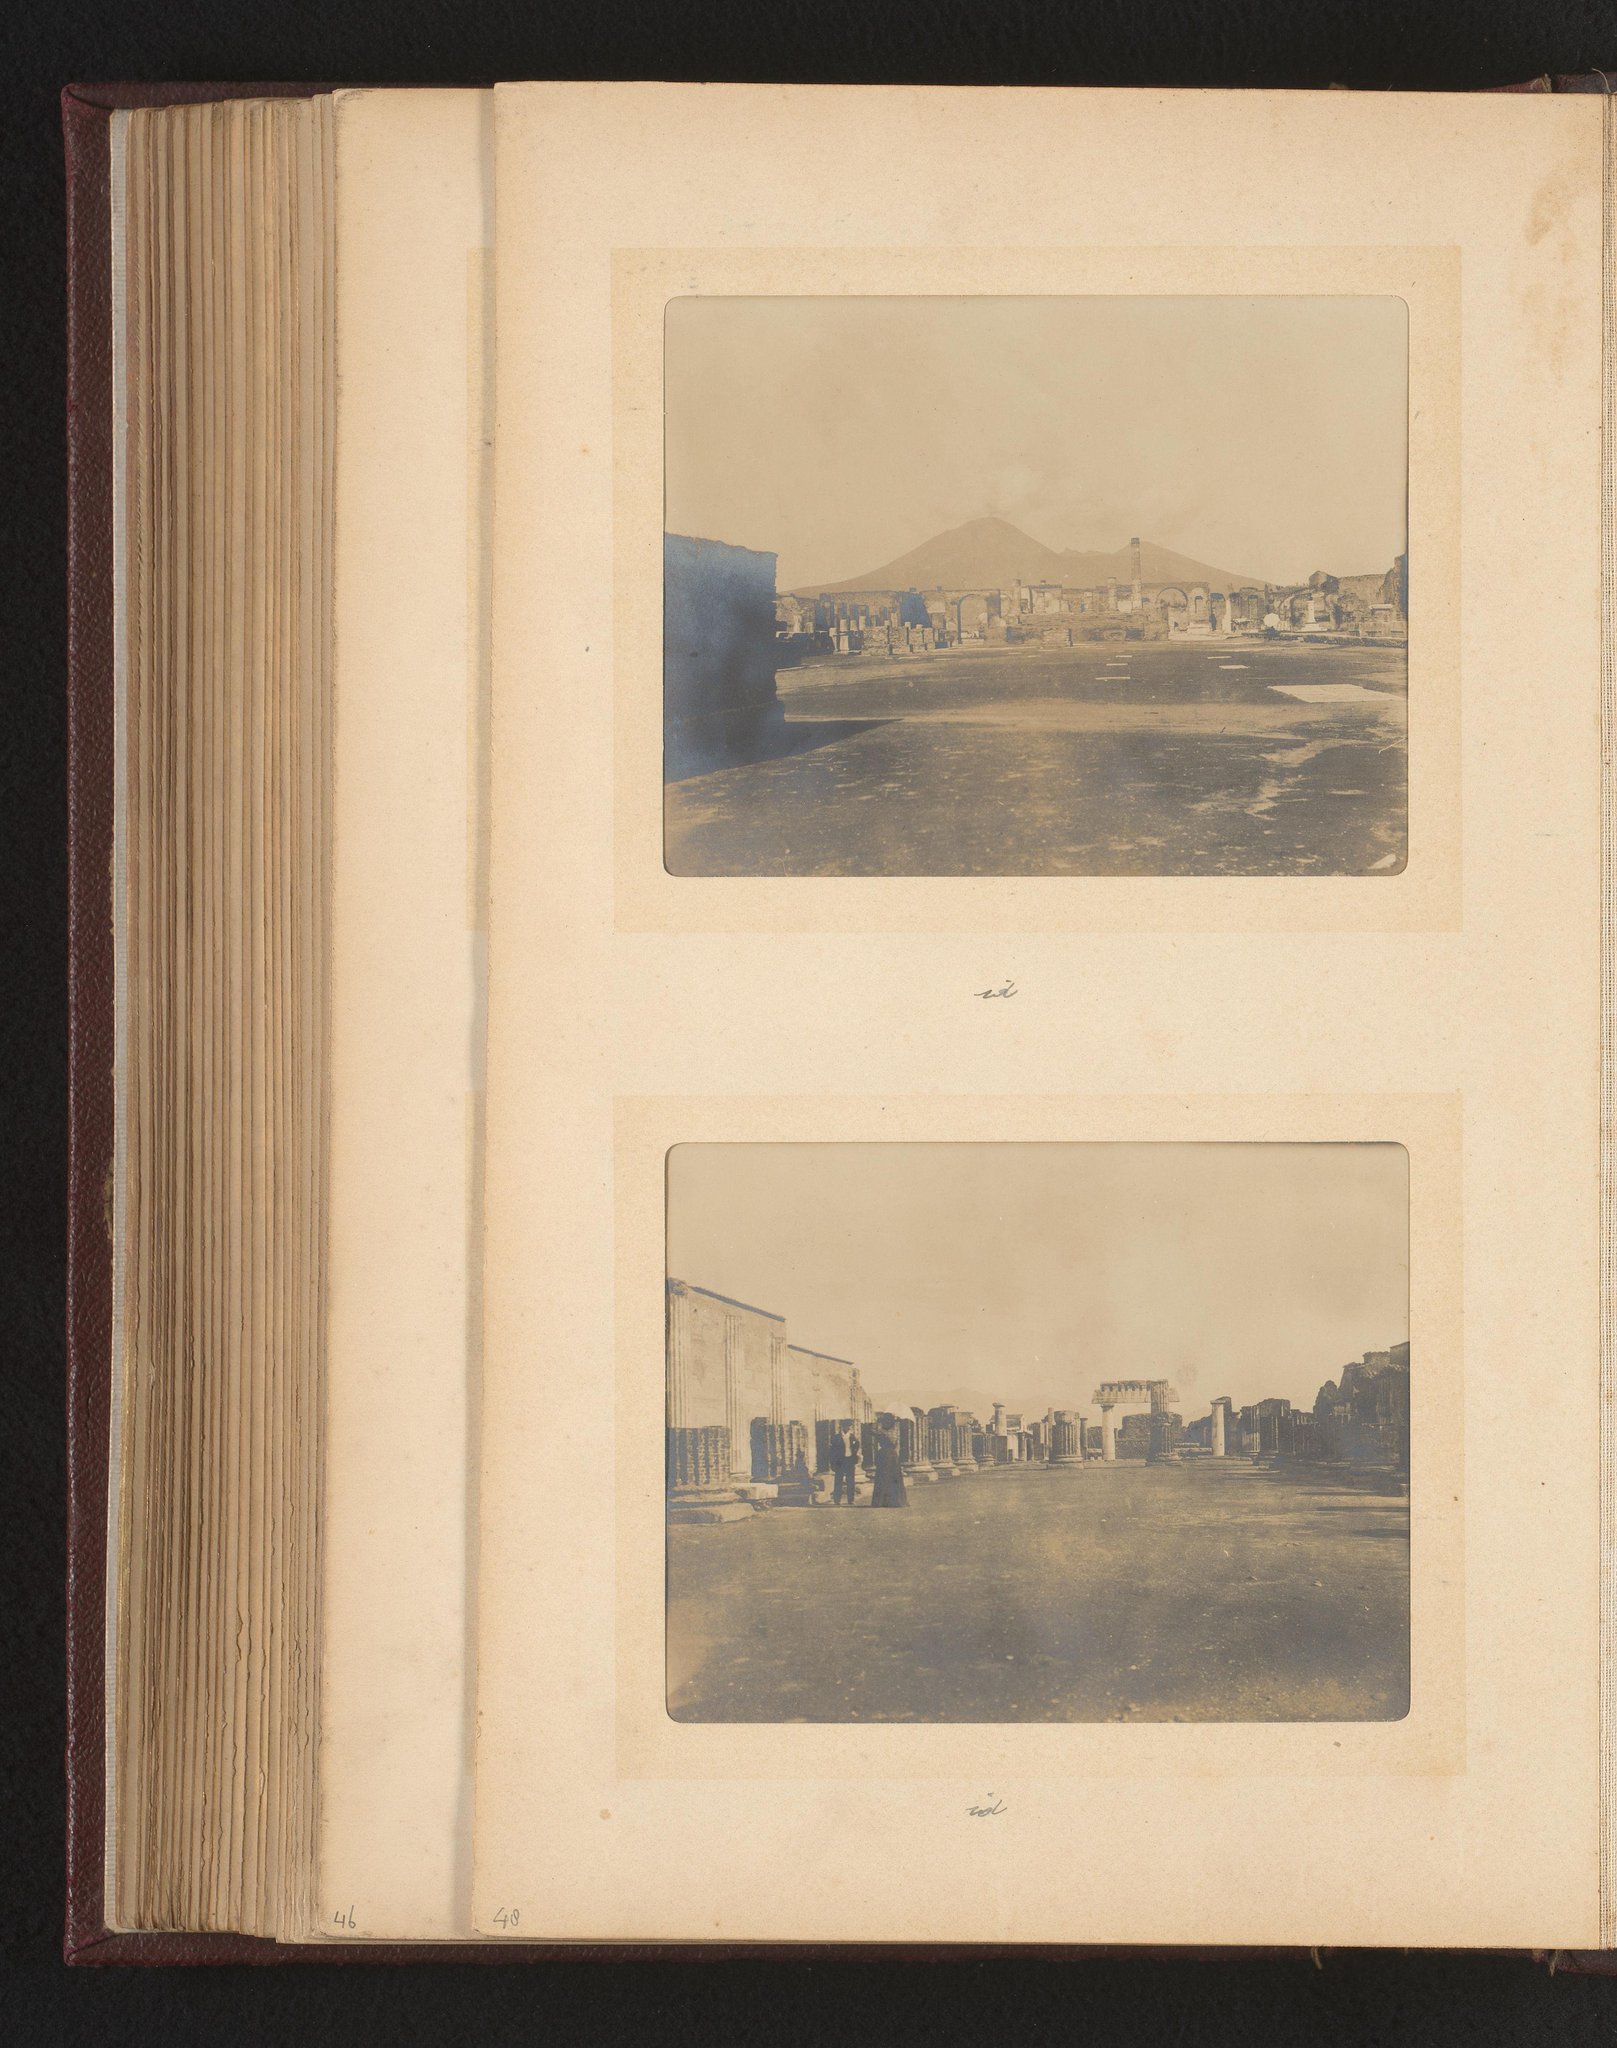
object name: photograph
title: Twee gezichten te Pompeï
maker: Anonymous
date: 1895-1905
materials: cardboard, photographic support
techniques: gelatin silver print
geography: pompeii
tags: tourism, landscape with ruins, volcano, mount vesuvius, pompeii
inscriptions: inscription: ‘id. / id.’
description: Albumblad met twee foto's in Pompeï. Onderdeel van een fotoalbum van een reis door Italië, ca. 1900.